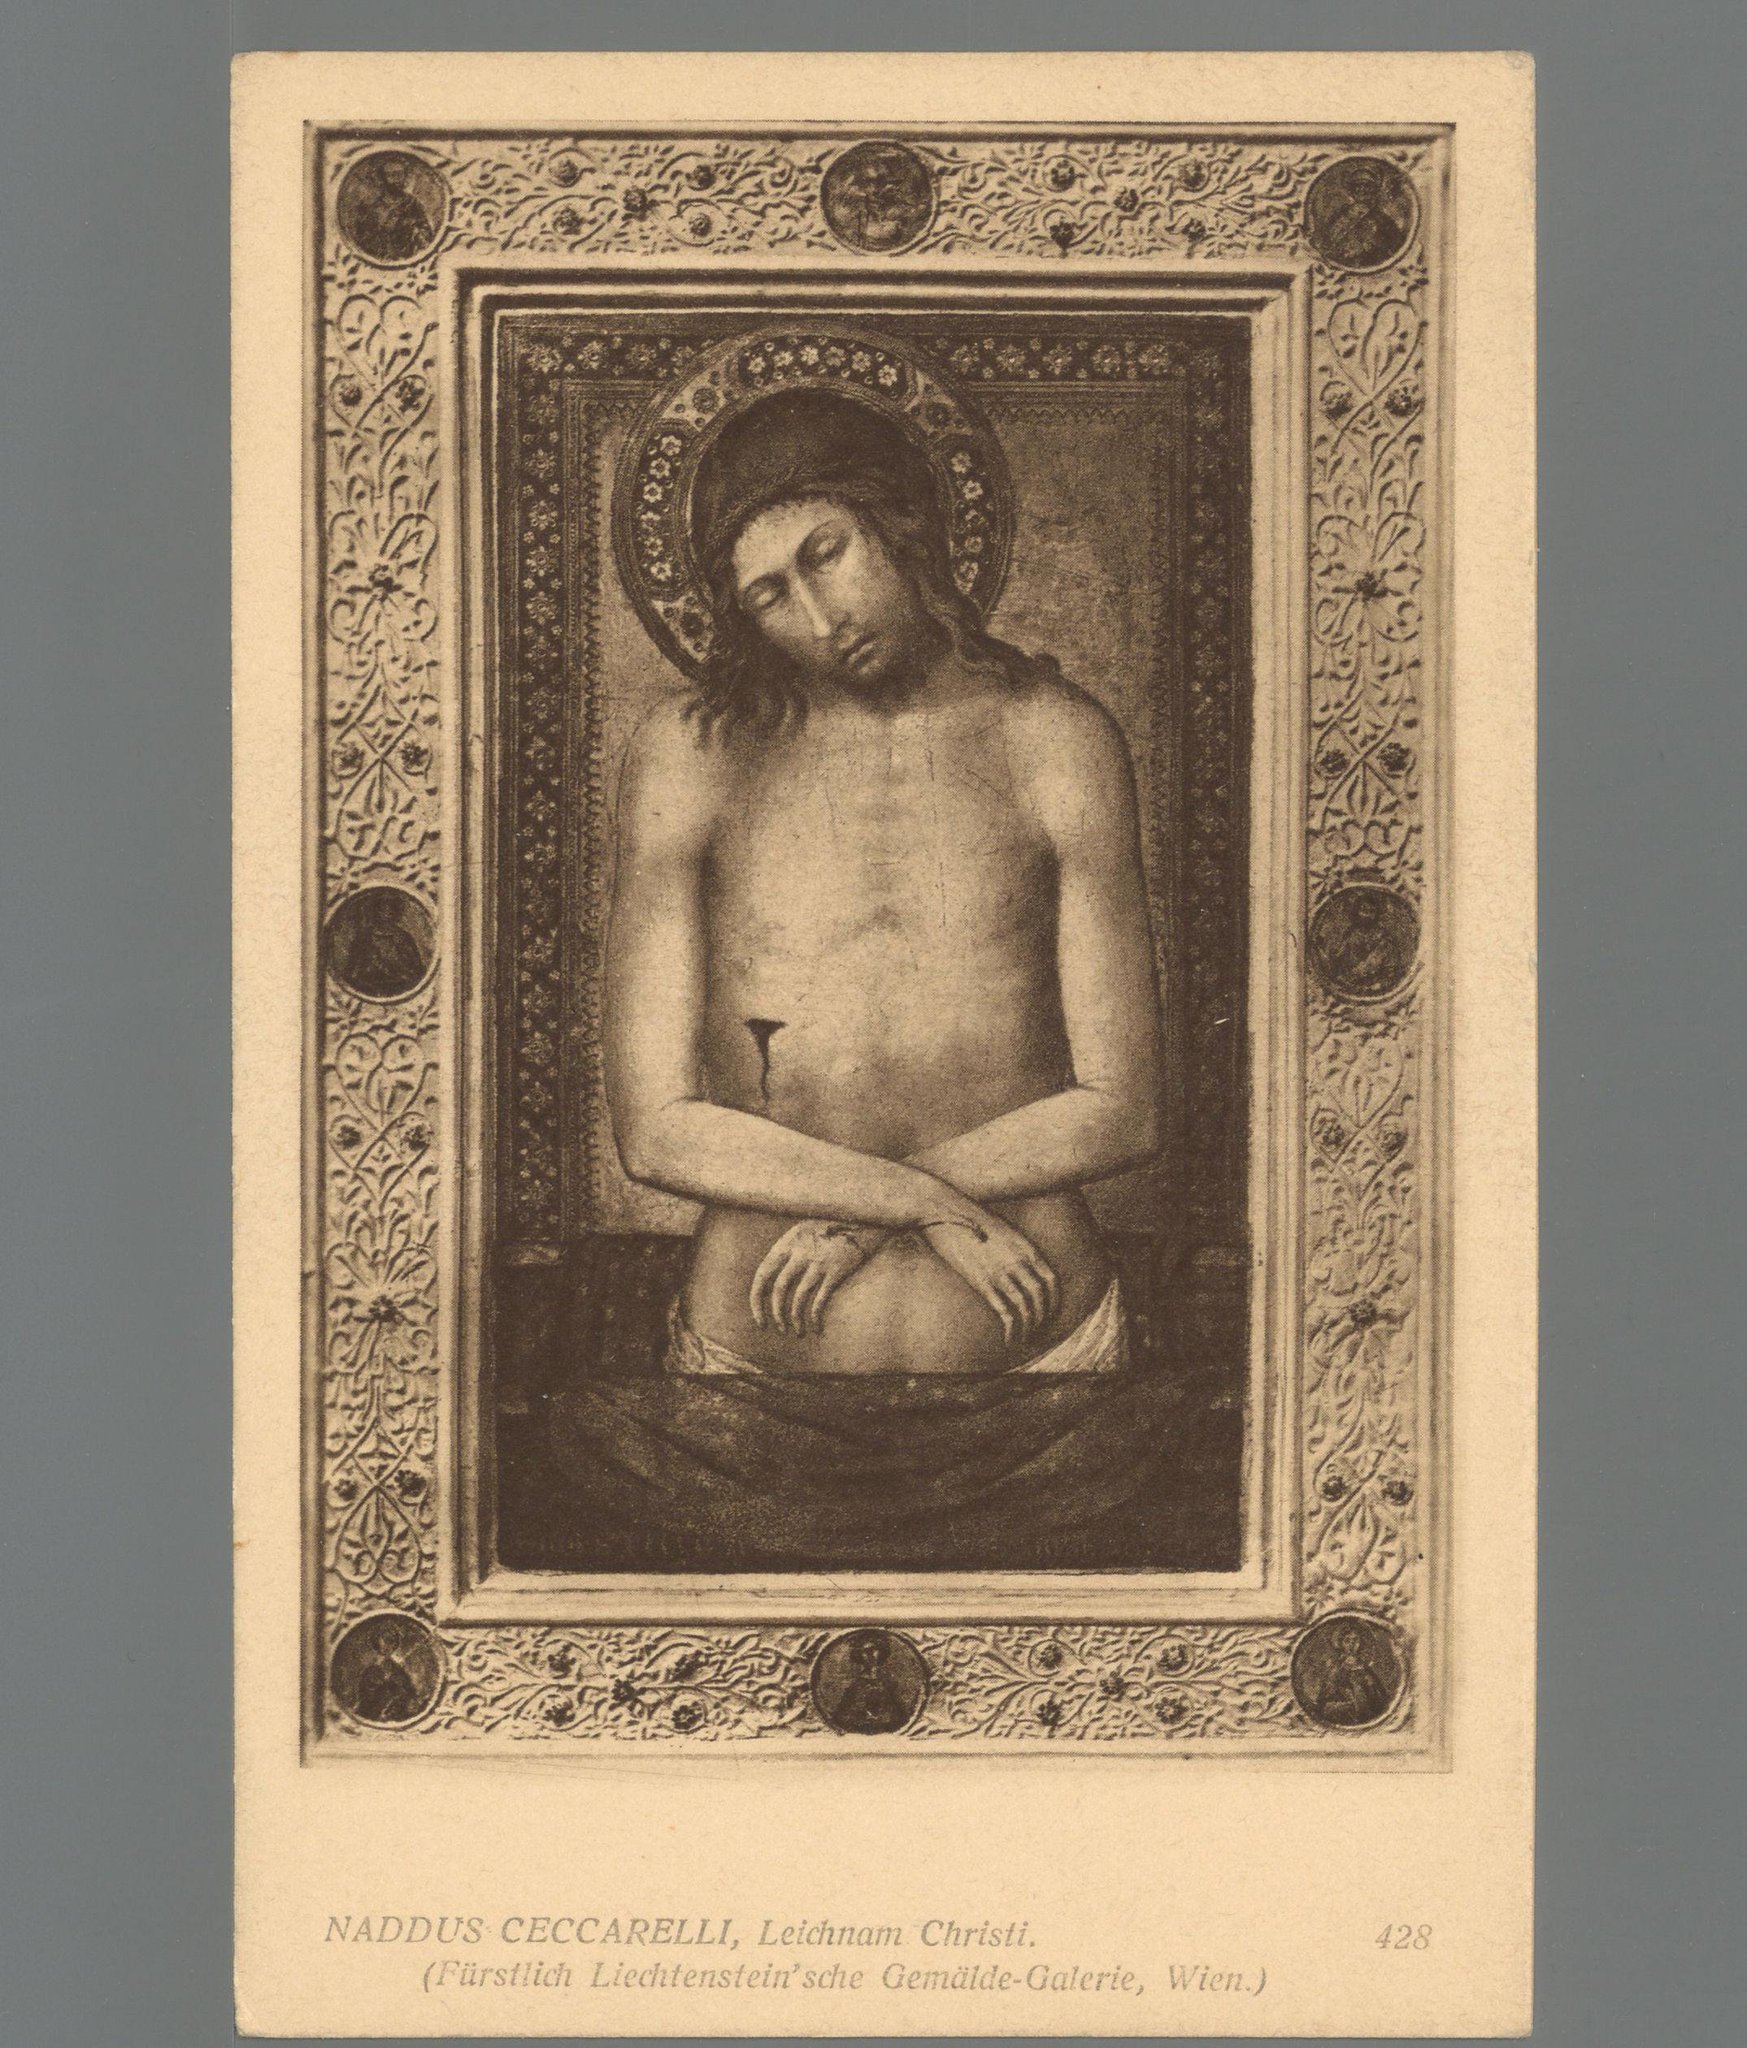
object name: reproduction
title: Naddus Ceccarelli, Leichnam Christi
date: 1914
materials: cardboard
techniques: rotogravure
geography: vienna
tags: christ as adult, violent death, being killed; being mishandled and maltreated; seeking death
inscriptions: date